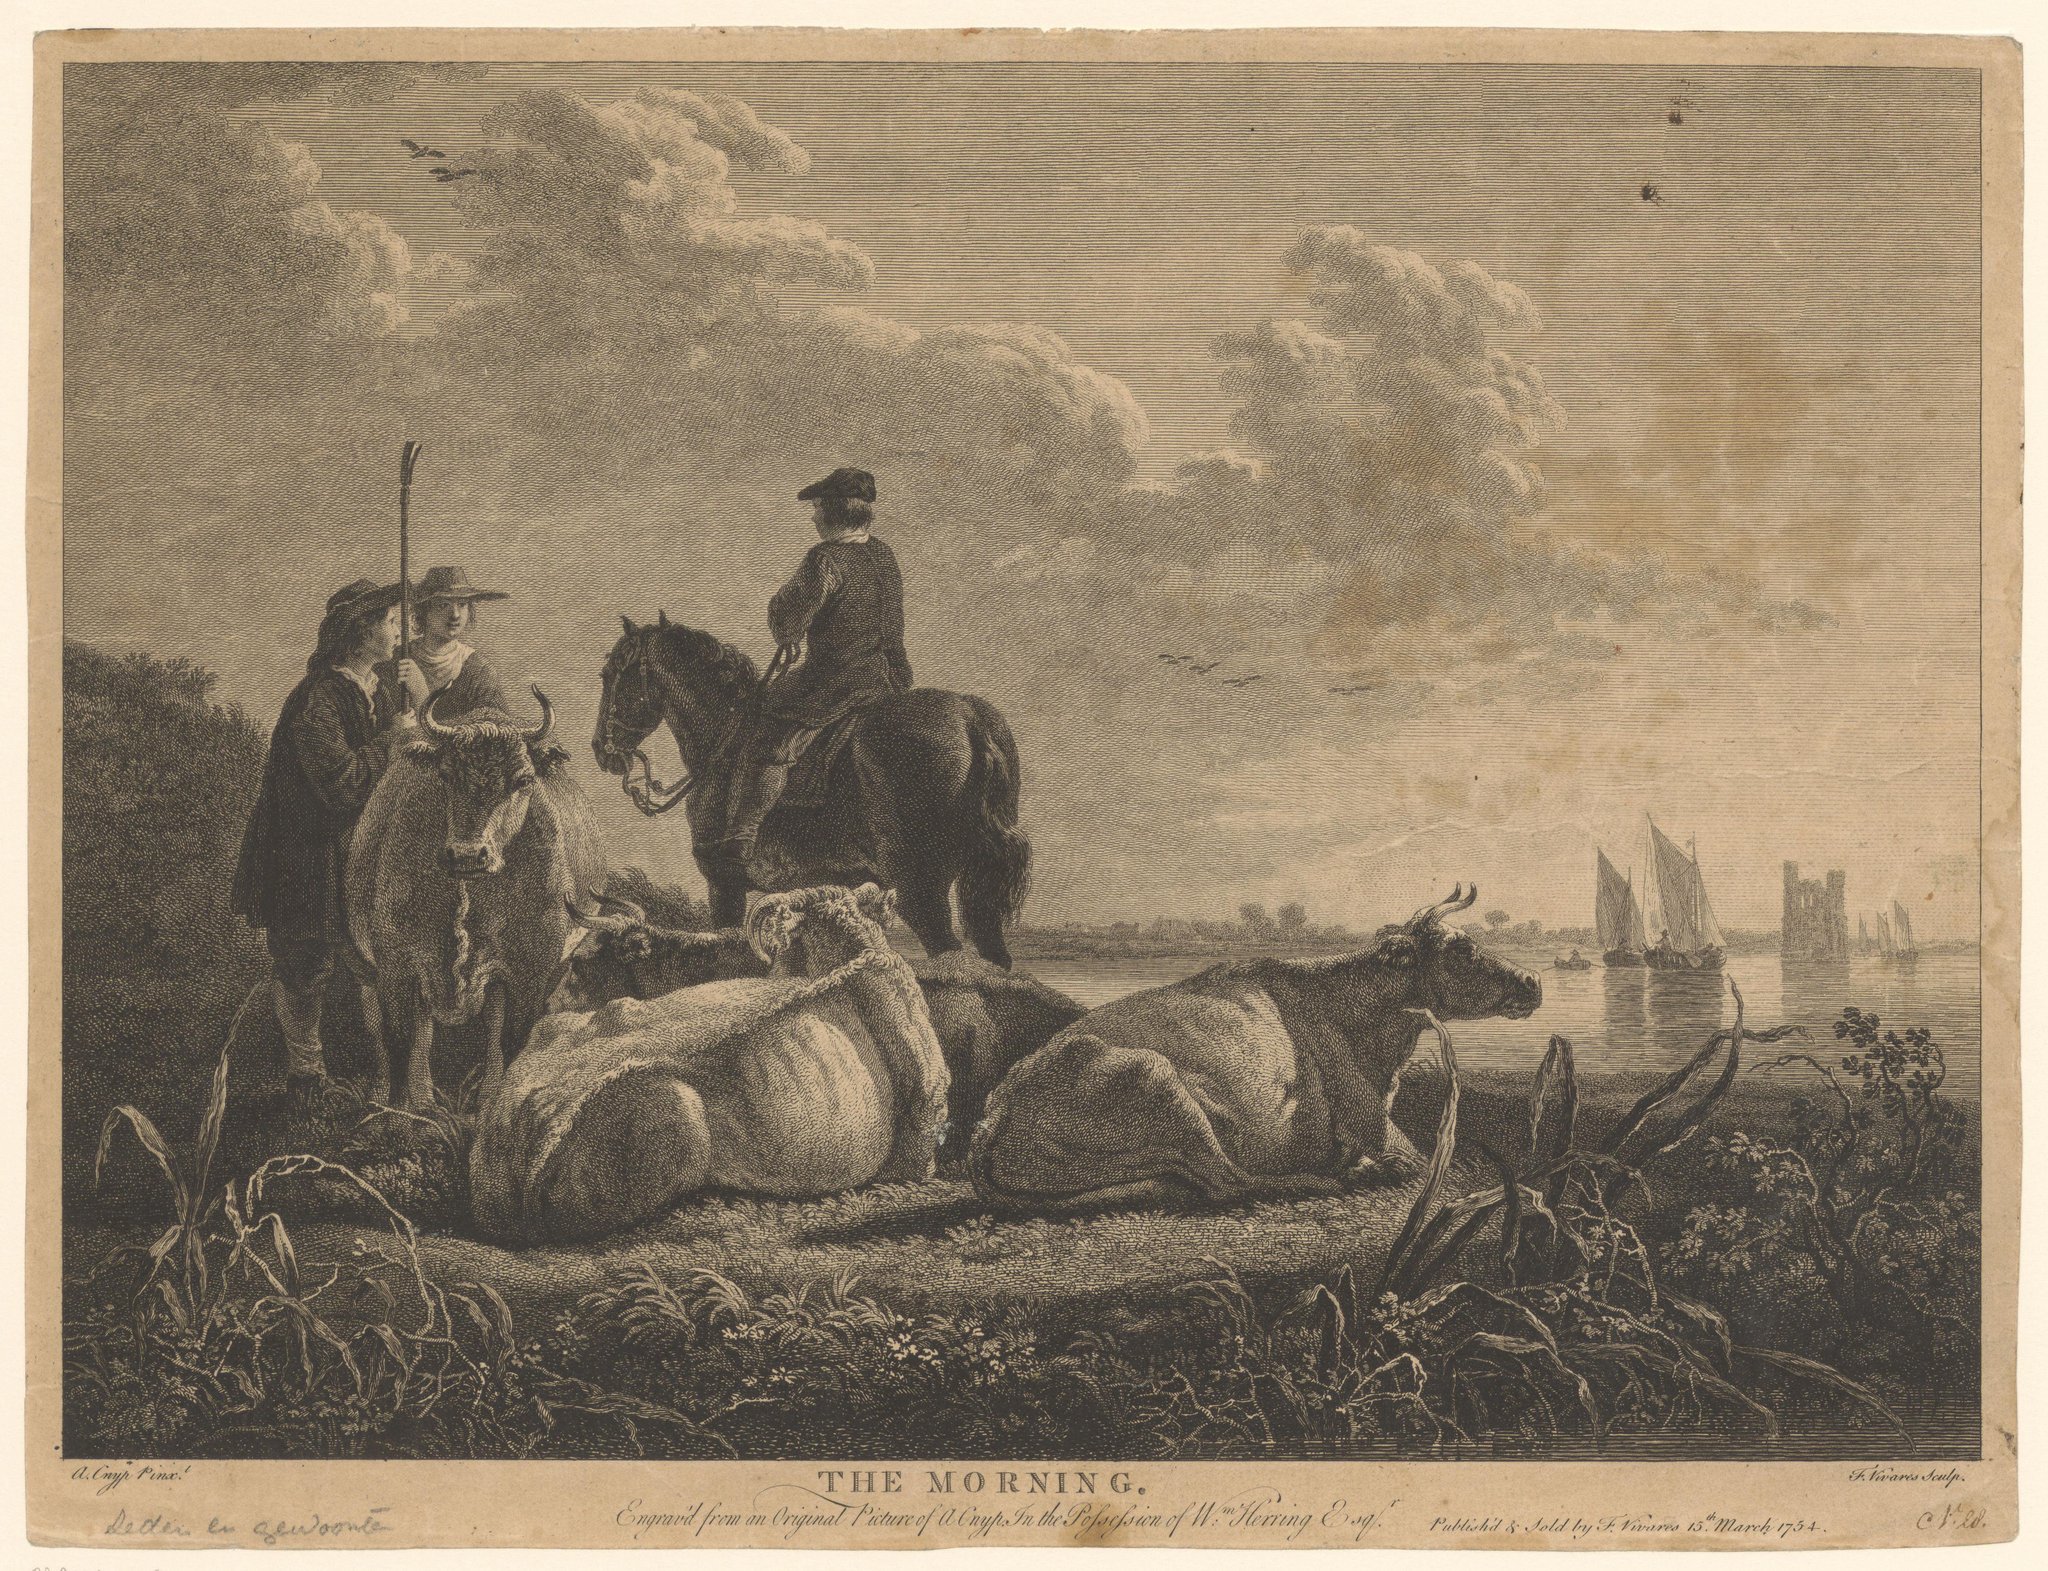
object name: print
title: Herders en ruiter bij koeien aan het water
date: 1754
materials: paper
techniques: engraving, etching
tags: cow, morning, river bank, herd, flock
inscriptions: collector's mark: Lugt 2228, annotation: ‘Daden en gewoontes’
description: Herders met kudde koeien in ochtendlandschap bij een rivier.